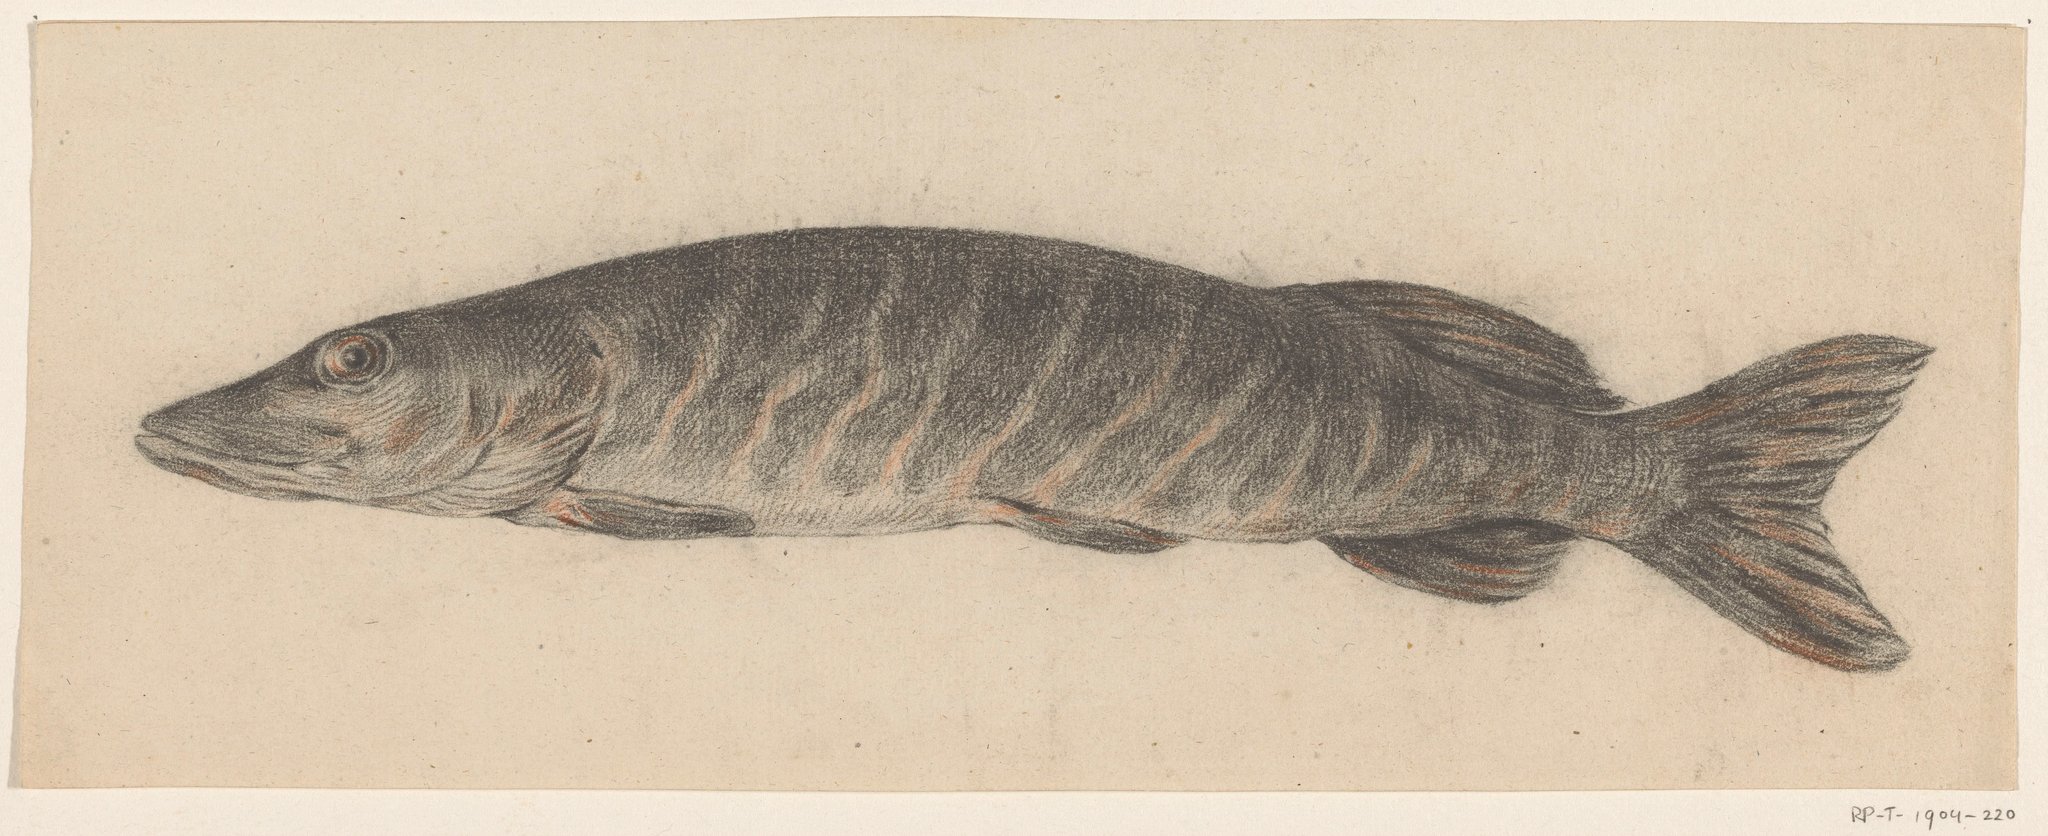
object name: drawing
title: Snoek, naar links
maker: jean bernard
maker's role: draughtsman, print maker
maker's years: 1765-1833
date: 1775-1833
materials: chalk, paper, pencil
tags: bony fishes: pike